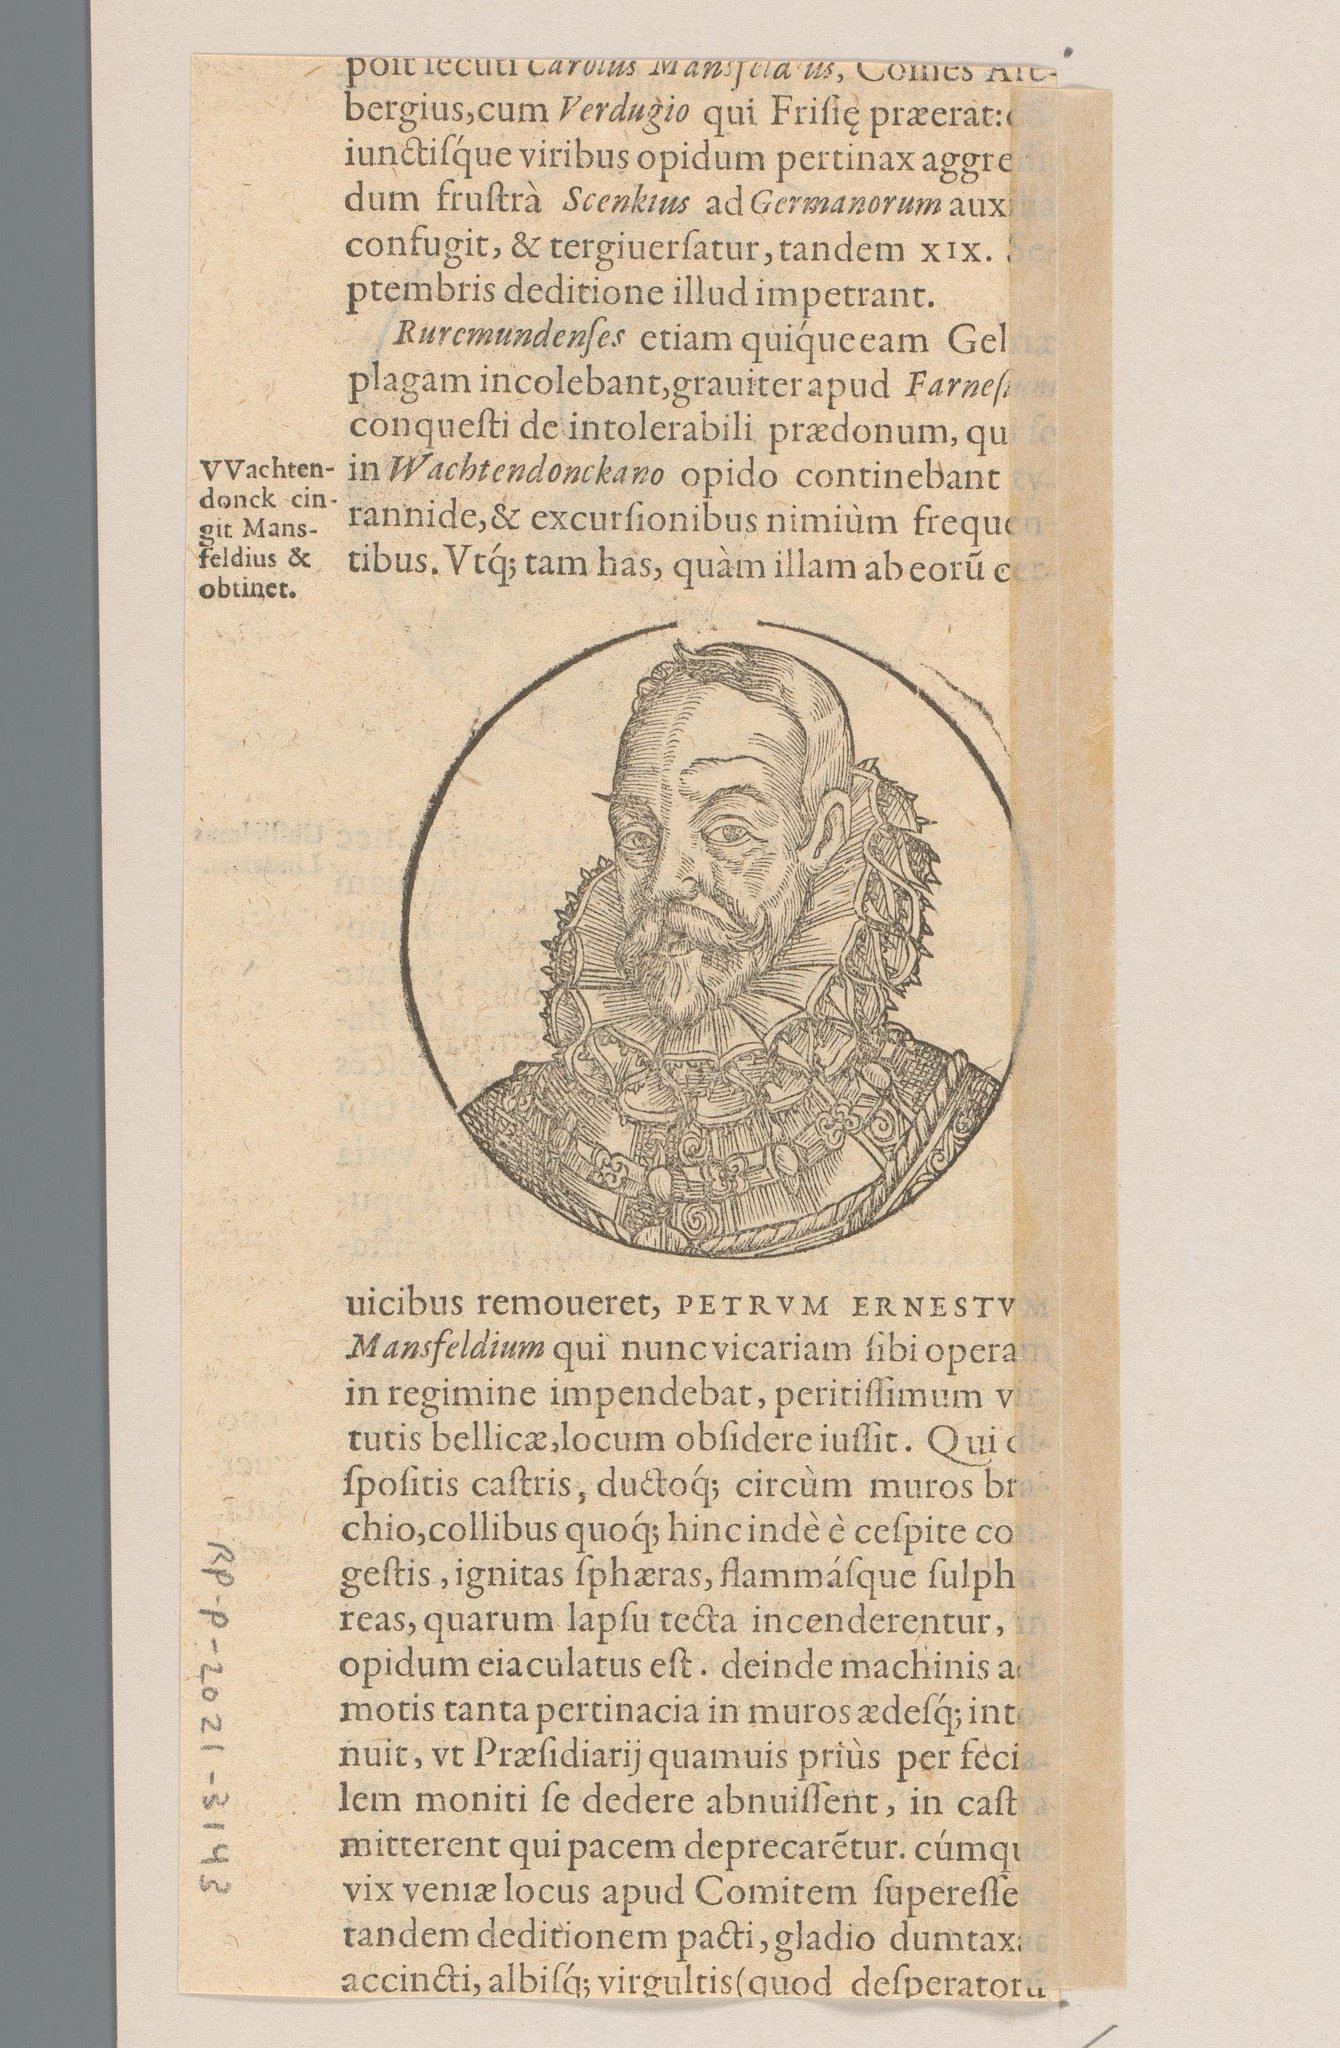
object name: book illustration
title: Portret van Peter Ernst I van Mansfeld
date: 1611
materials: paper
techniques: letterpress printing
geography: antwerp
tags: historical persons, governor, etc. of province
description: Prent uit: Beyerlinck, Laurens. Opus chronographicum orbis universi a mundi exordio (...). Antwerpen: Hieronymus Verdussen, 1611, dl. 2, p. 159.